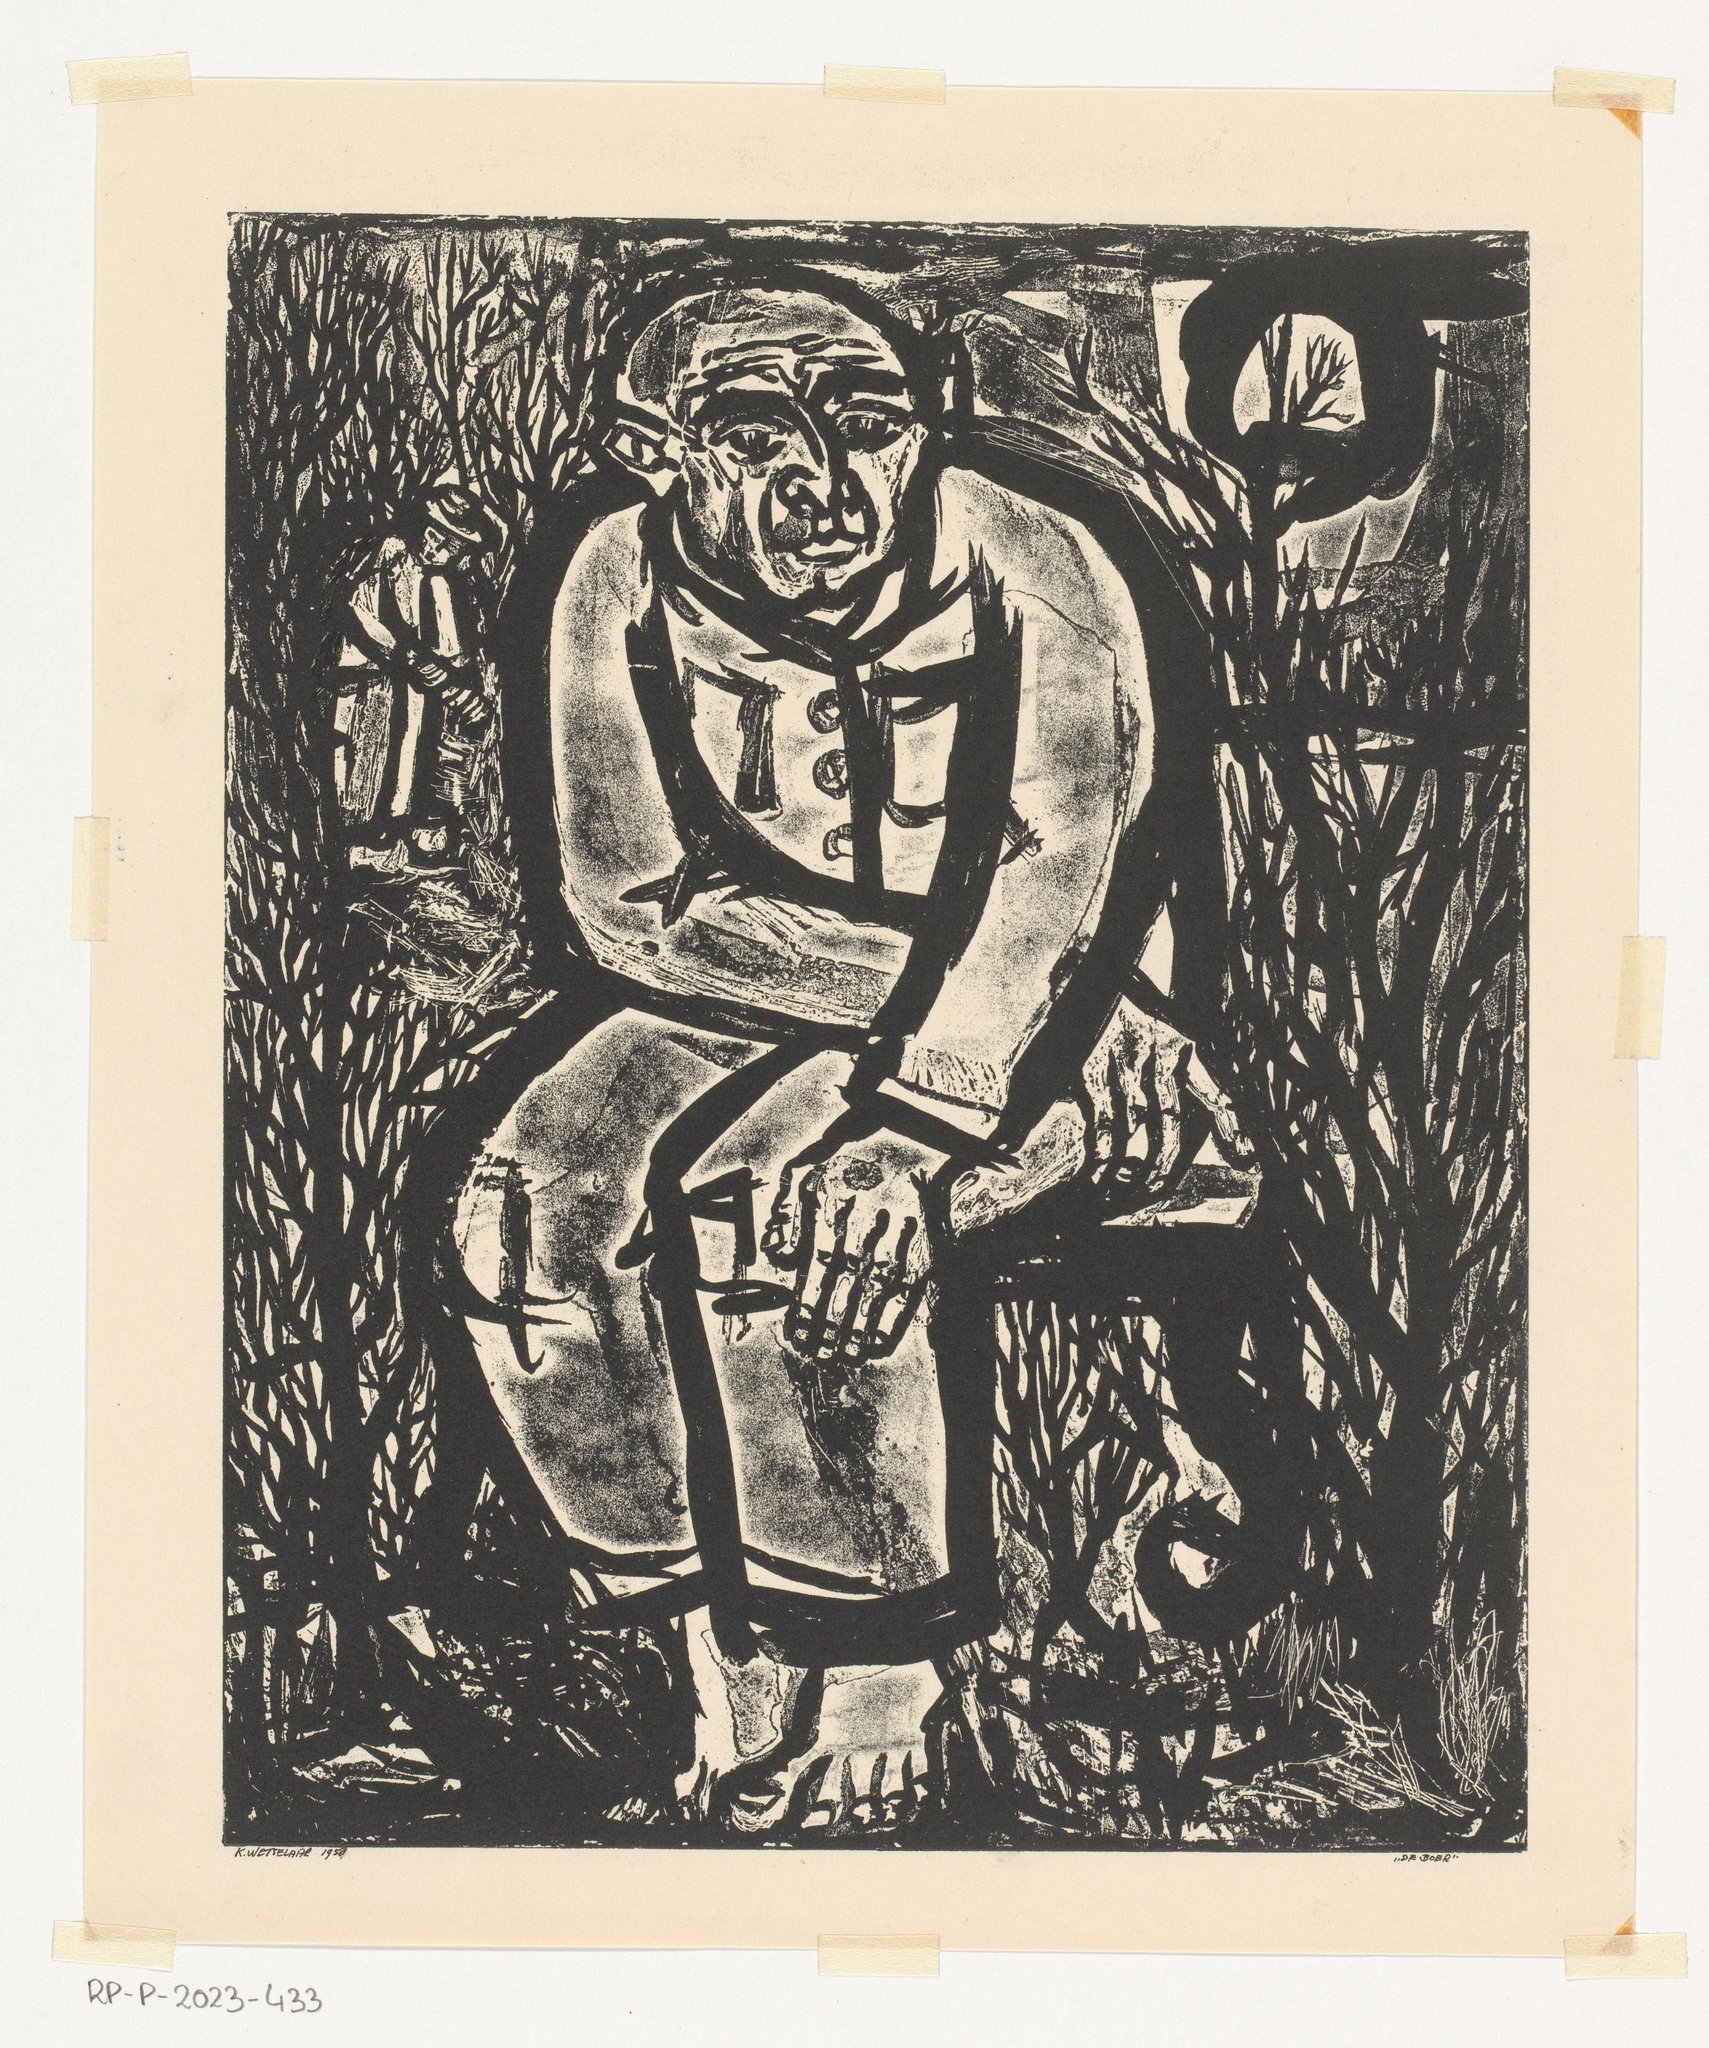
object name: print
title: De Boer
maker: karel wetselaar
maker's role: print maker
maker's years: 1935-2017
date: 1958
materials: ink, paper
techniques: intaglio, linocut, pen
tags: trees, farmers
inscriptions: signature and date: ‘K. Wetselaar 1958’